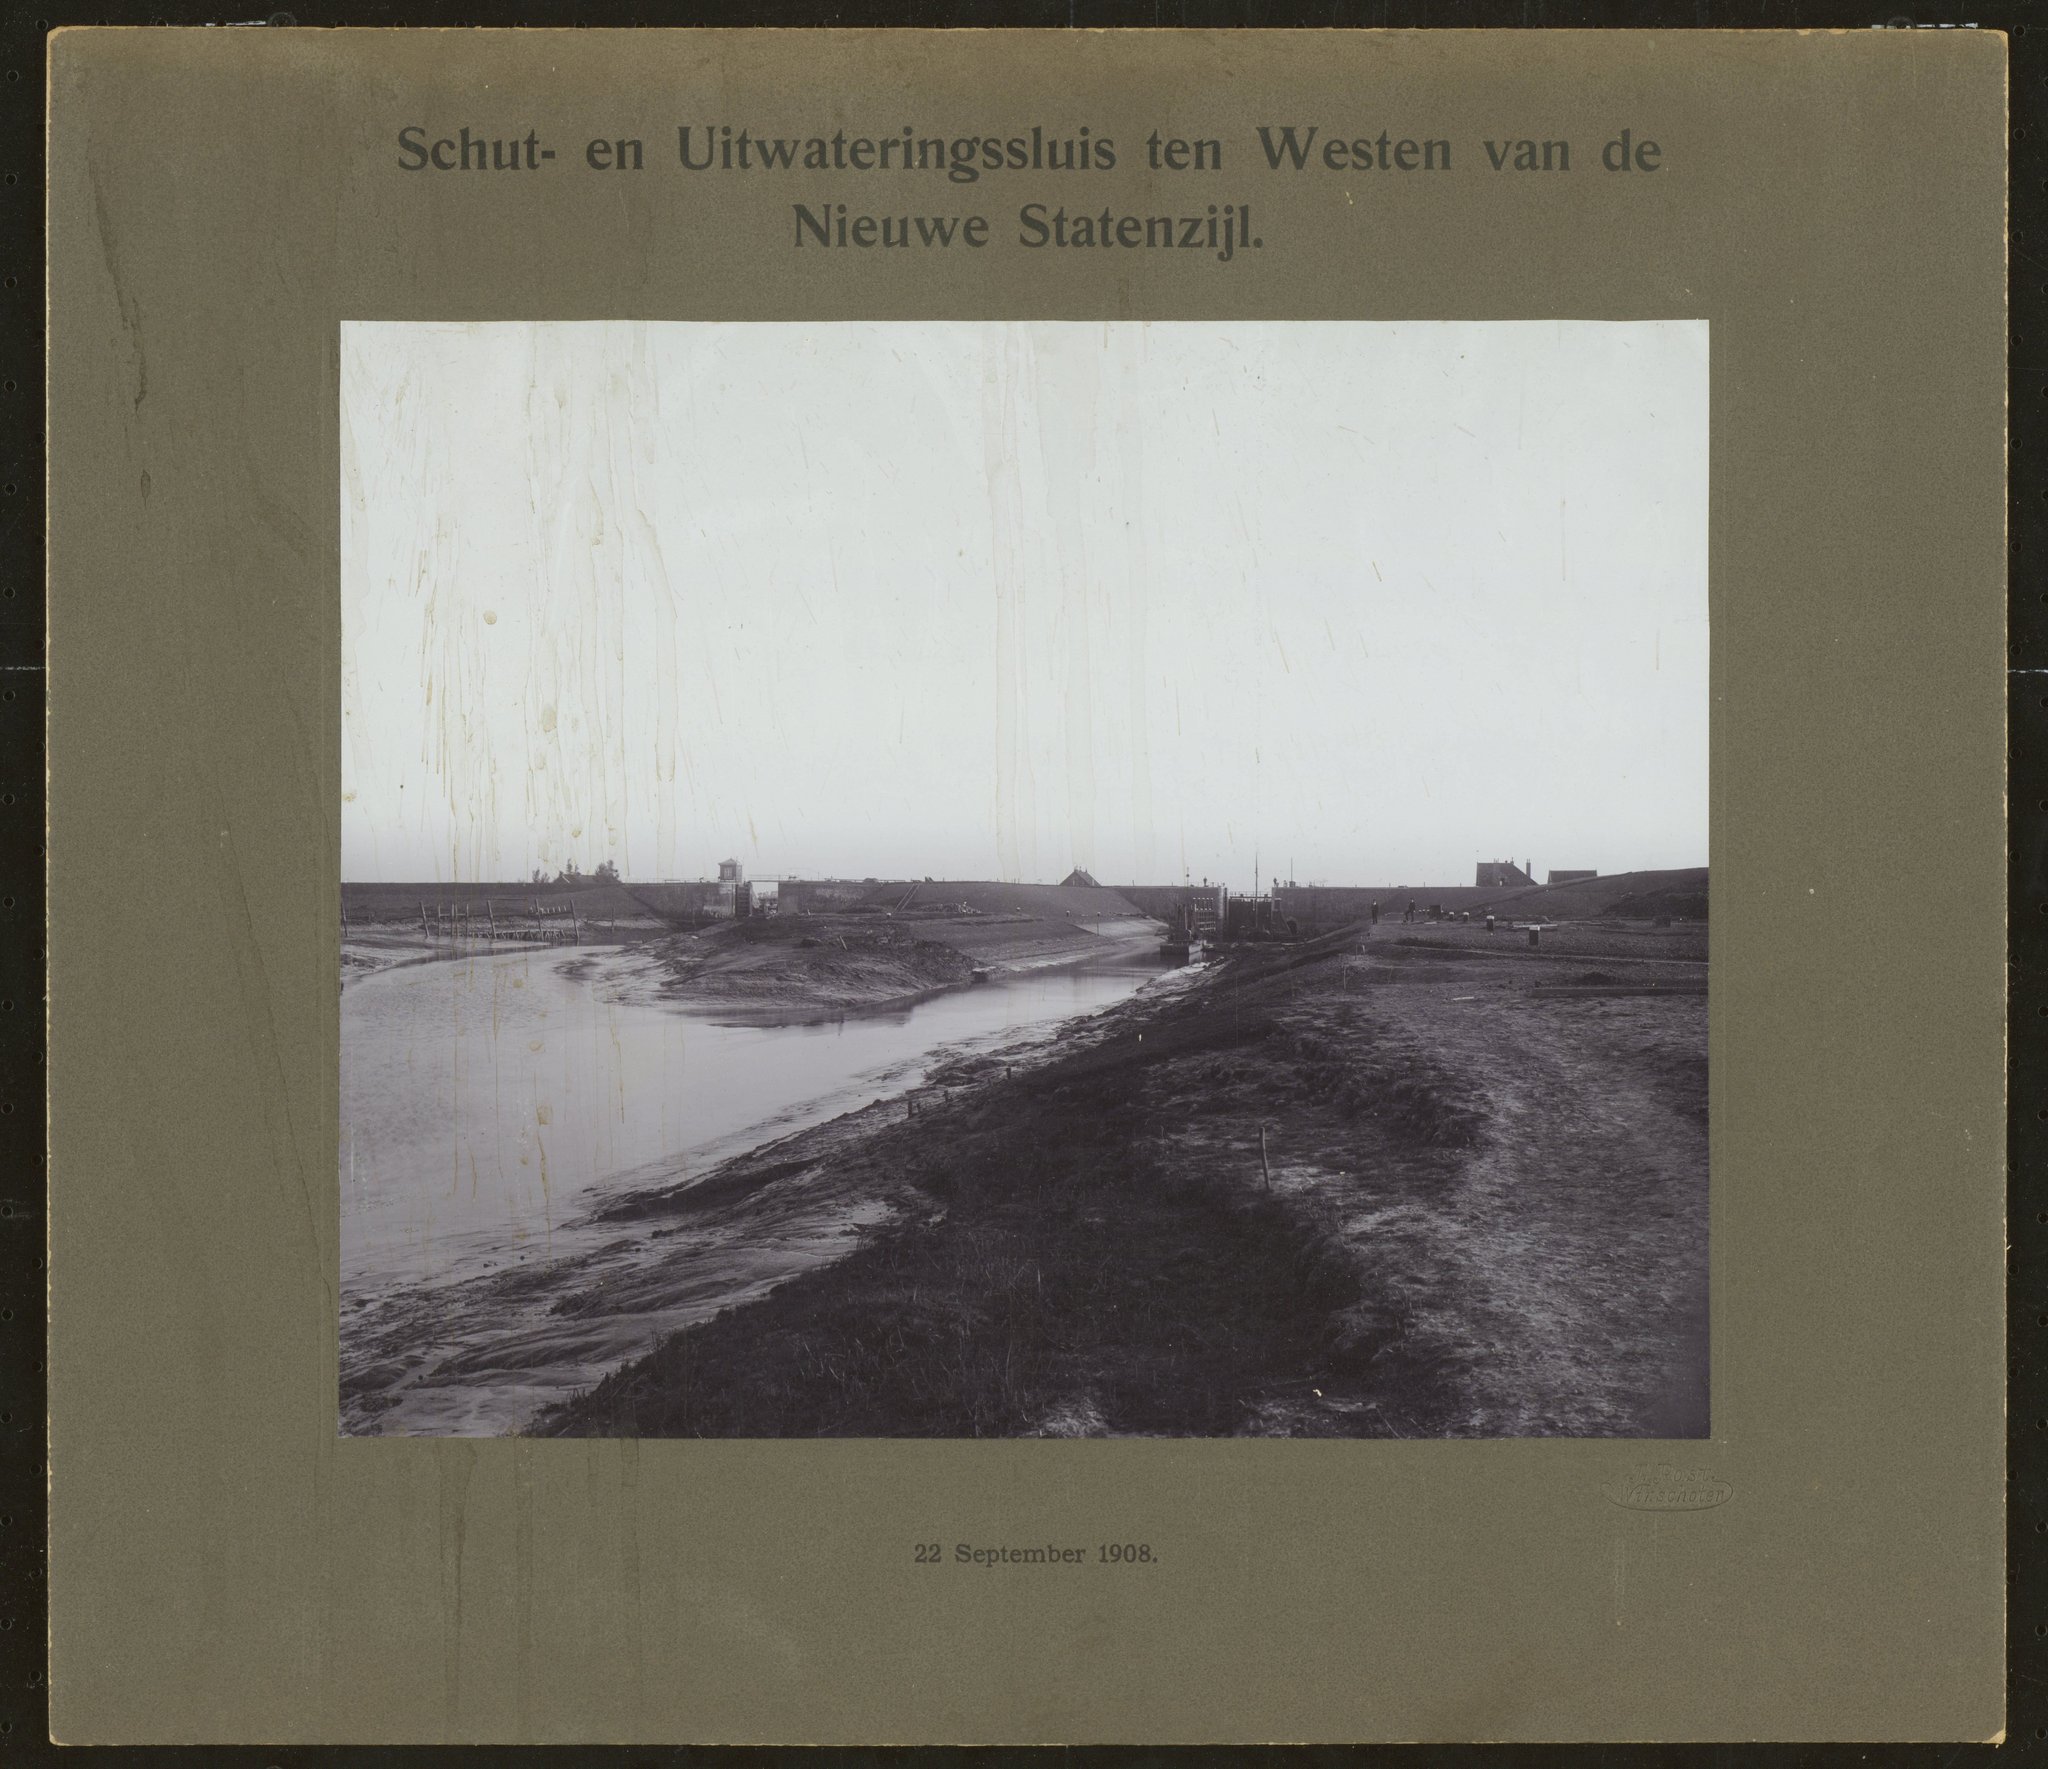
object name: photograph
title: Schut- en Uitwateringssluis ten Westen van de Nieuwe Statenzijl 1907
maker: tonnis post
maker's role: fotograaf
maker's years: 1877-1930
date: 1908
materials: cardboard, paper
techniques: collodion silver print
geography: winschoten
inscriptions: date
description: Een van 8 foto's in cassette aangaande een sluis (bij Nieuwe Statenzijl). Foto op blauwgrijs karton geplakt, cassette: paars / bruin. Gedateerd. Opmerking: zie NG-1976-36-B-1 t/m 8.